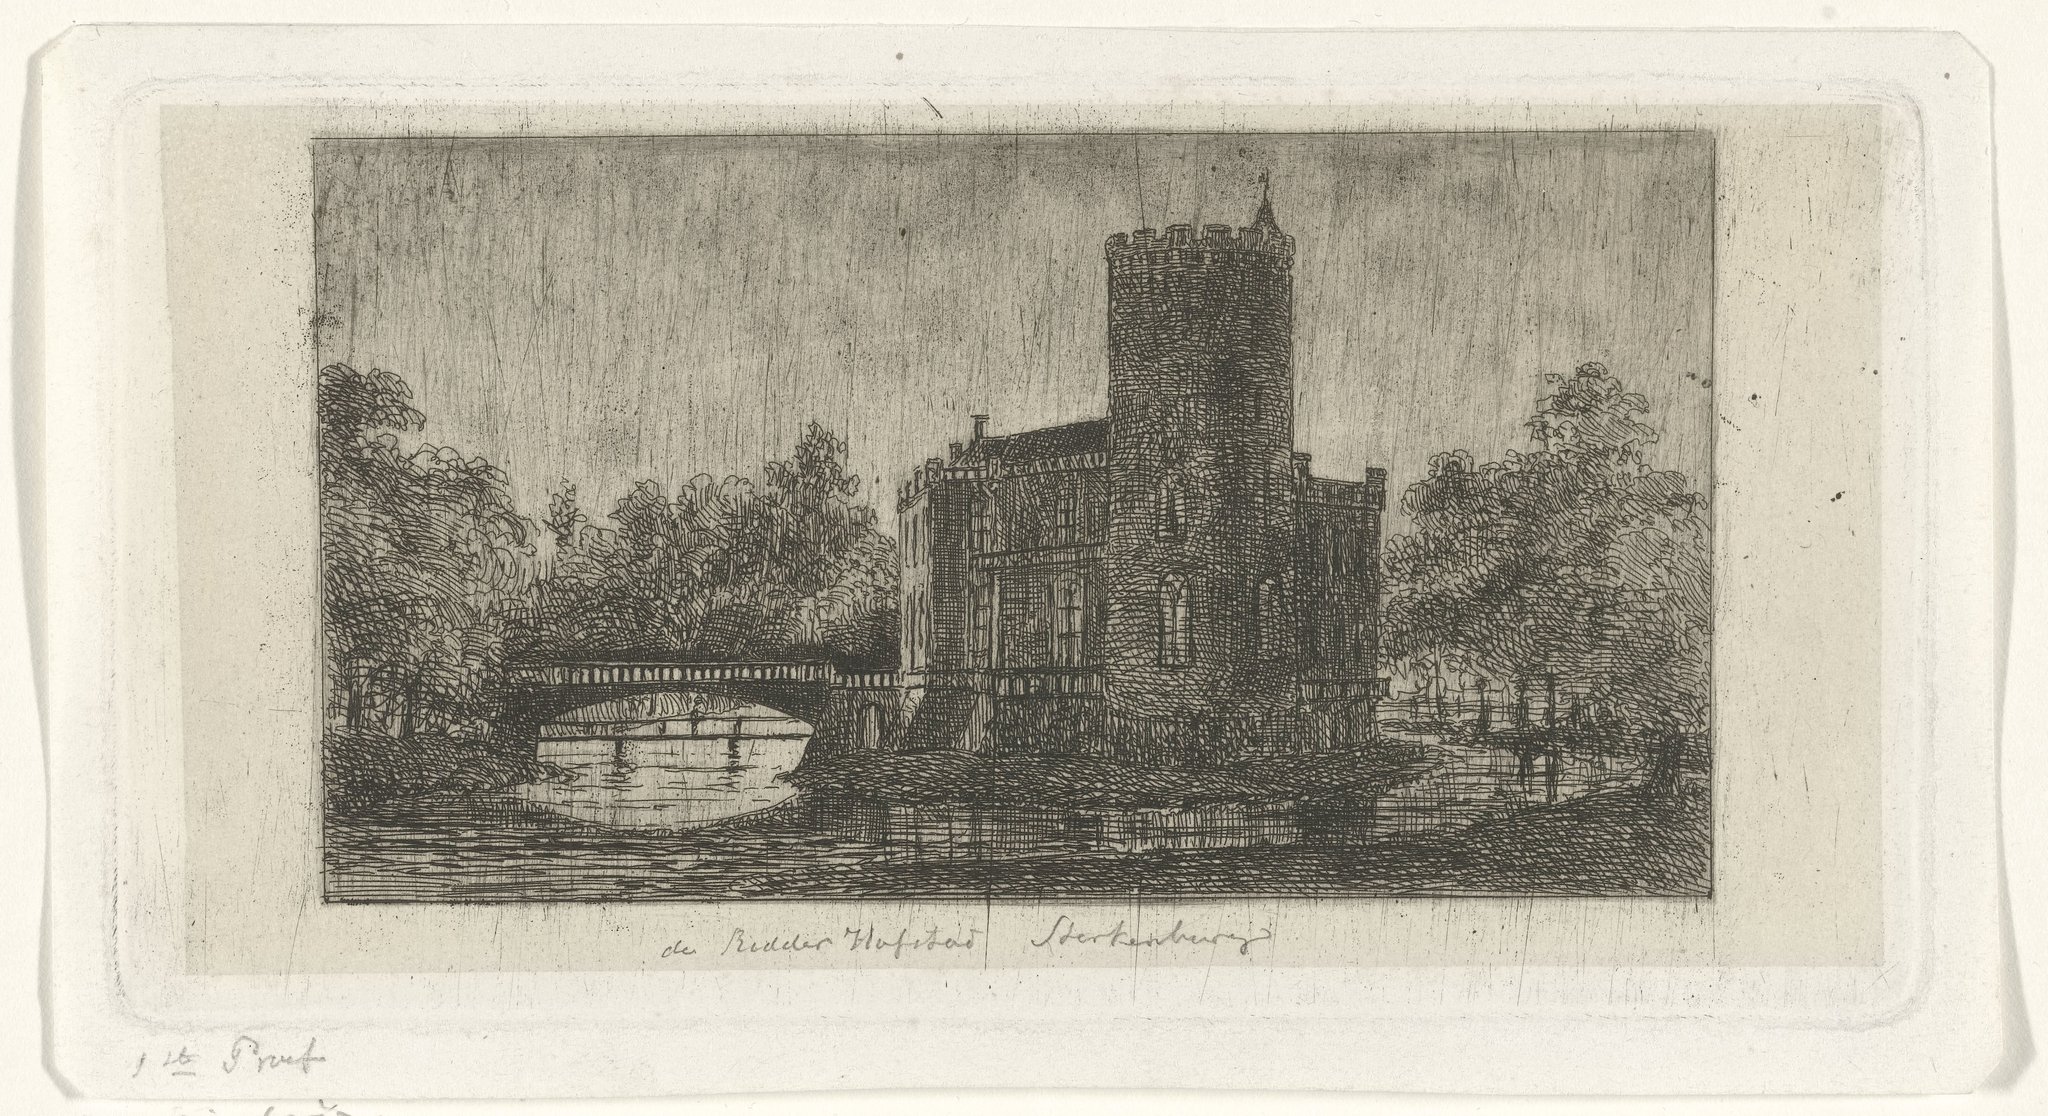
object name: print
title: Gezicht op Ridderhofstad Sterkenburg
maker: jacobus ludovicus cornet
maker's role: draughtsman, print maker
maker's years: 1815-1882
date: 1825-1882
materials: paper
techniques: etching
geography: leiden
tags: kasteel sterkenburg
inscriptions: collector's mark: Lugt 2228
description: Gezicht op het kasteel Sterkenburg, met links de brug naar het kasteel.